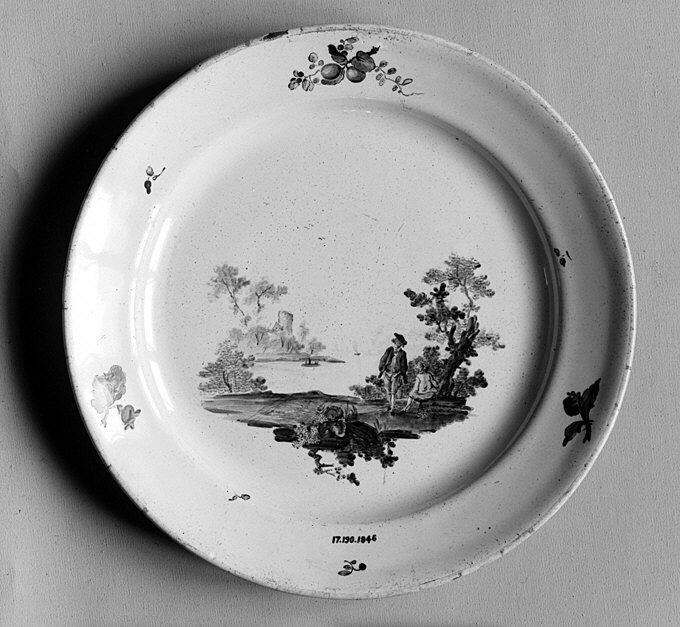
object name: plate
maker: fidelle duvivier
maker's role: decorator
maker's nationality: french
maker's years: 1740-1796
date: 1753-1795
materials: faience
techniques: glazing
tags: men,women,trees